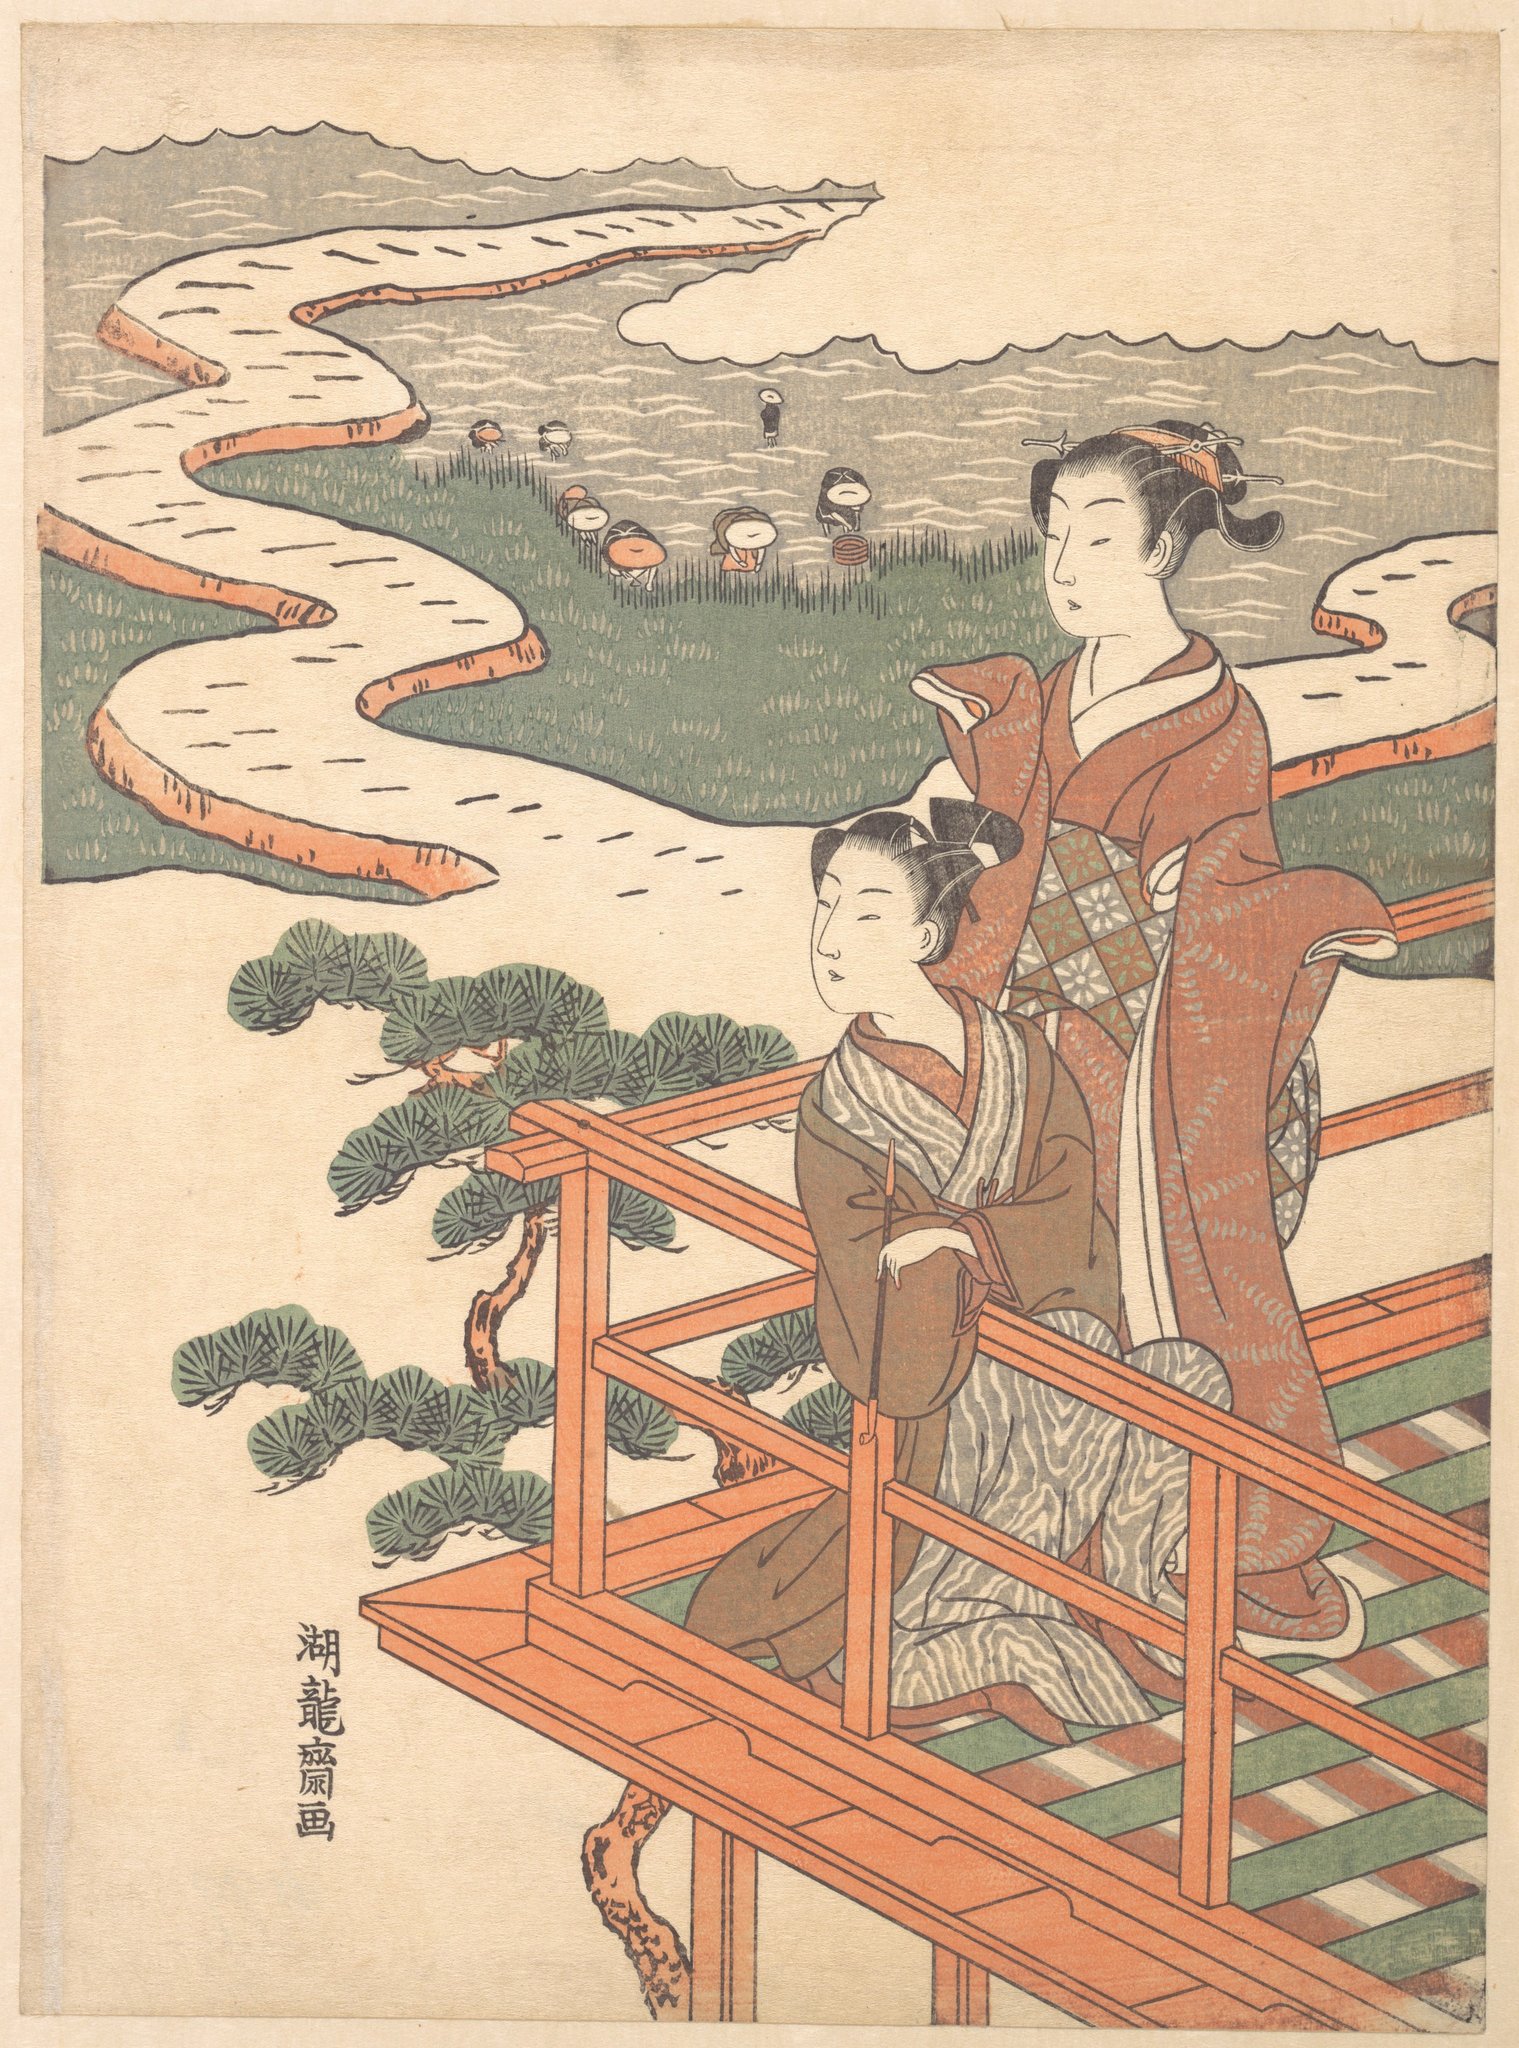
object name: print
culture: japanese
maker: isoda koryūsai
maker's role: artist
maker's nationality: japanese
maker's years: 1735-1790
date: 1770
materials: ink, paper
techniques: woodblock print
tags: women,pipes